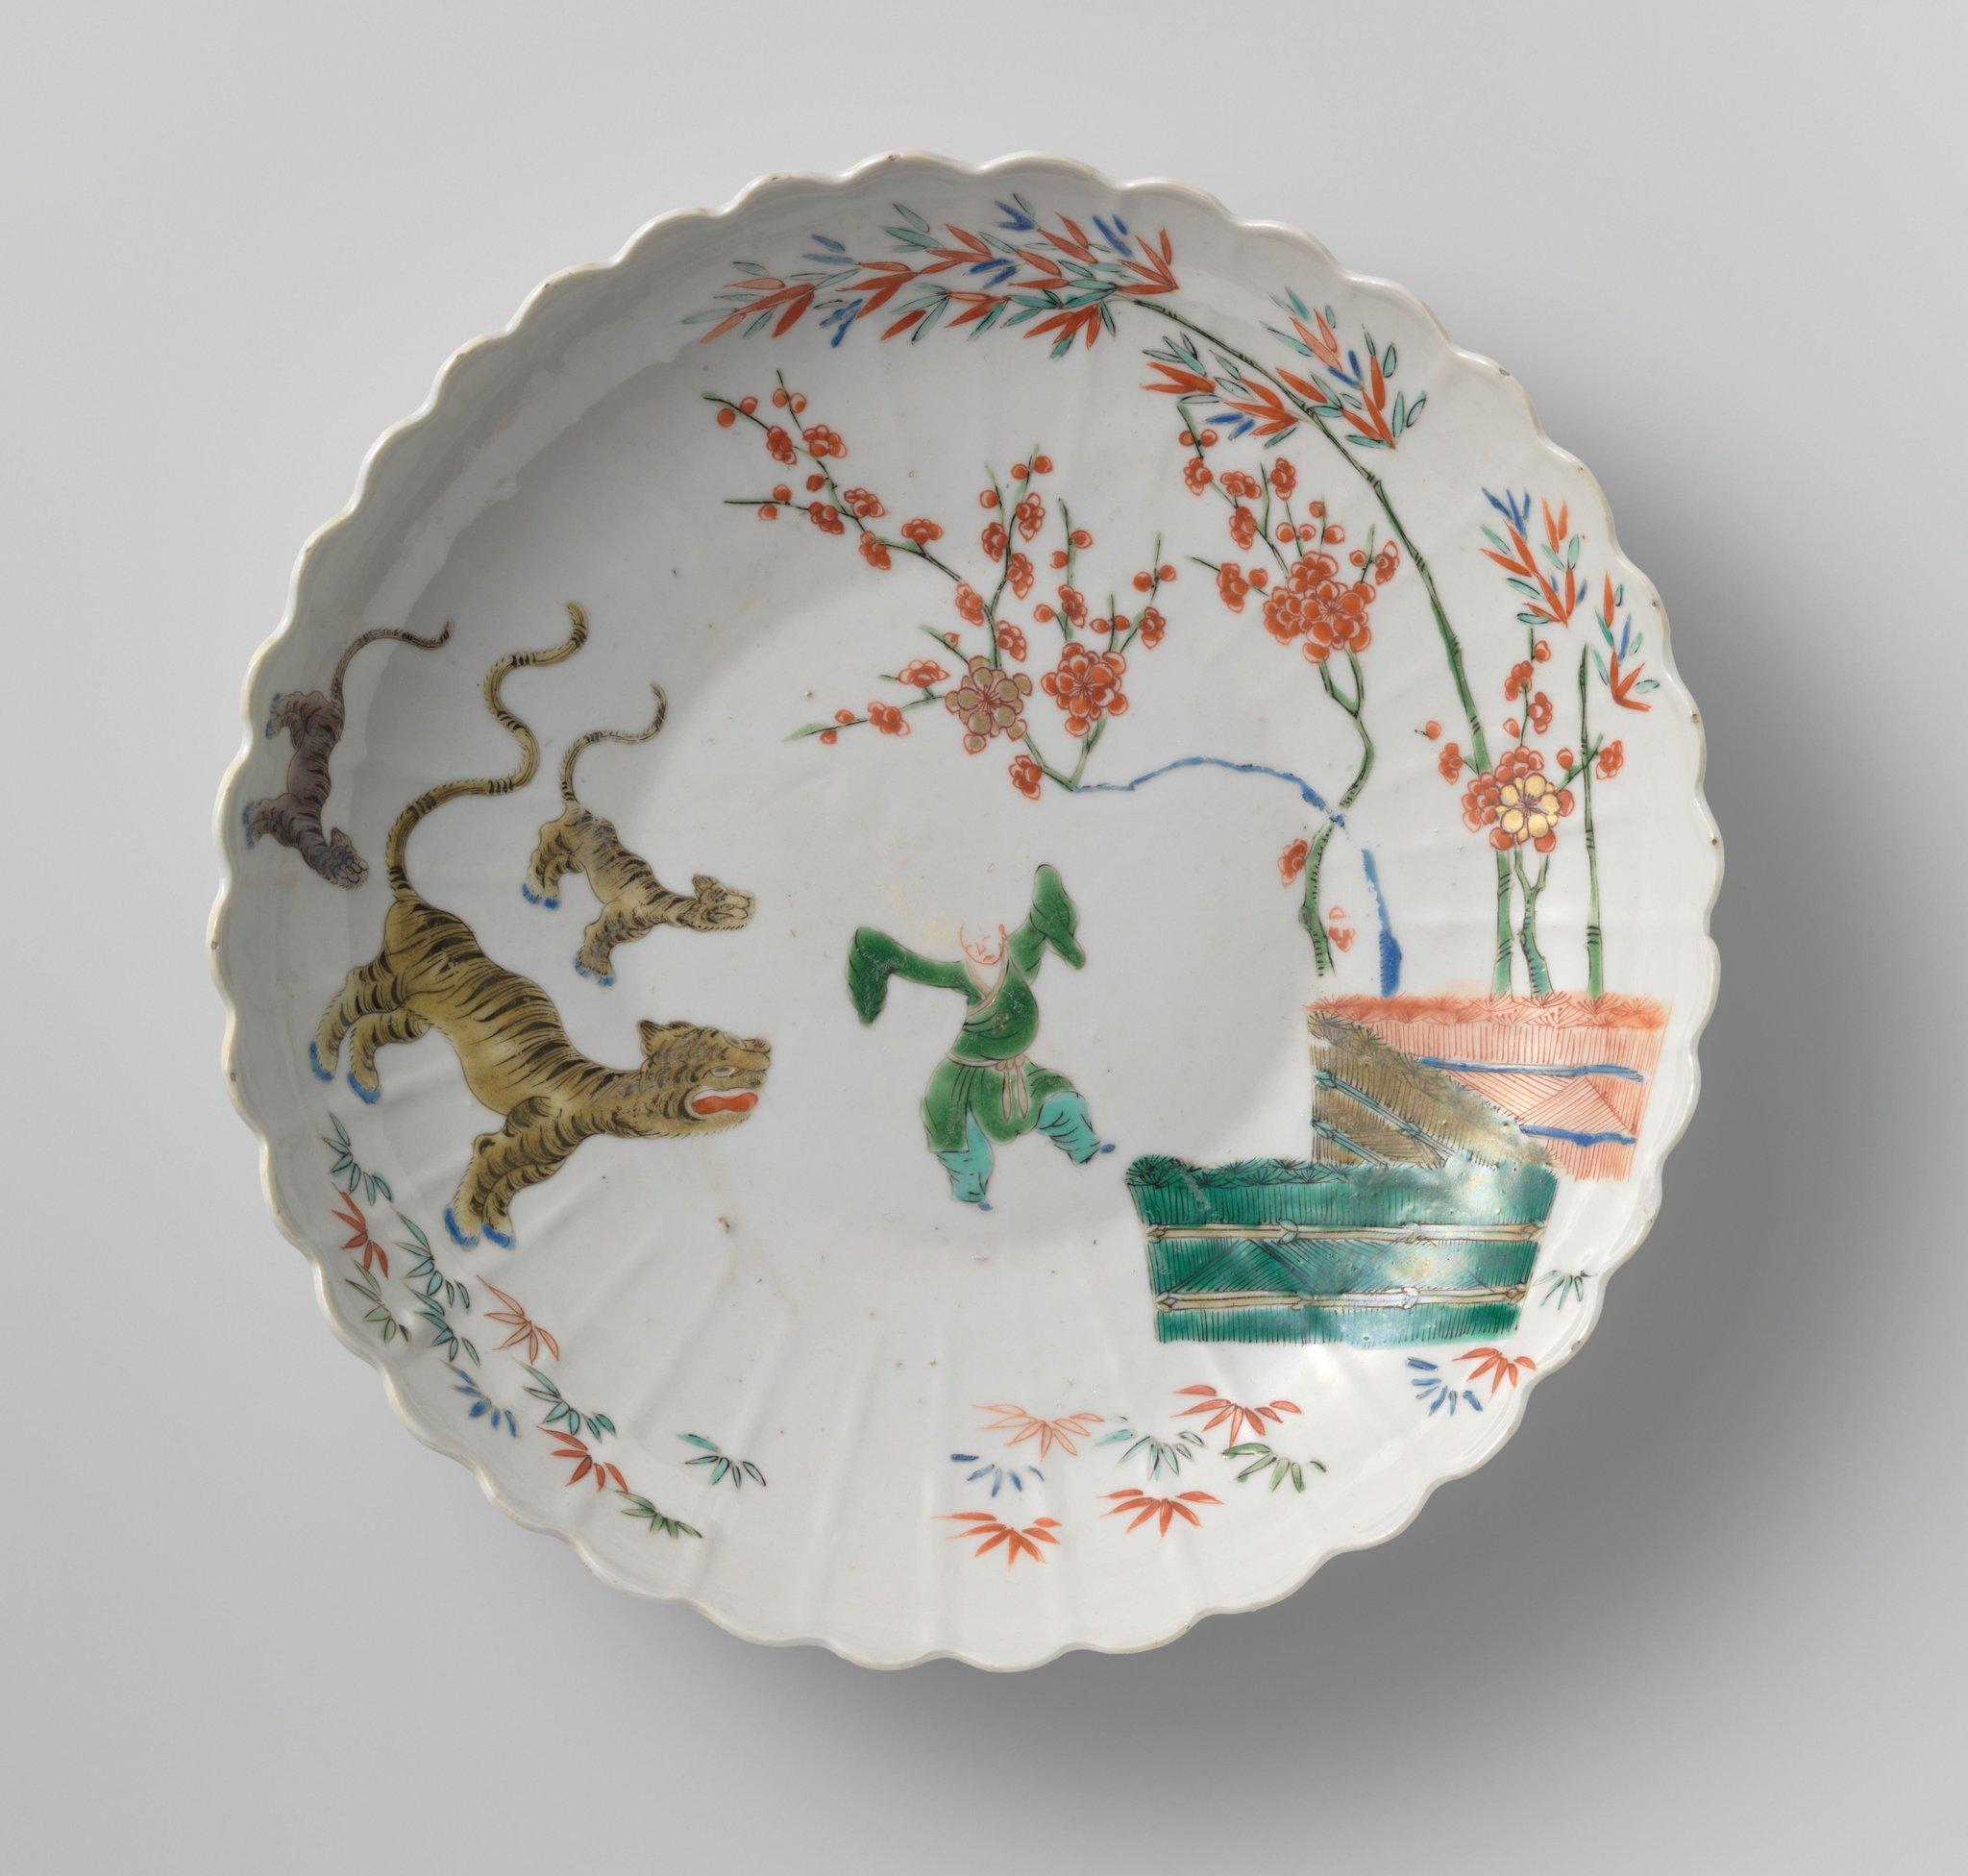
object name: dish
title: Saucer-dish with bamboo, prunus, tiger and a Chinese boy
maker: Anonymous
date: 1700-1724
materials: glaze, gold, paint, porcelain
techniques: firing, gilding, turning, vitrification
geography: china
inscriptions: label: ‘Collectie Westendorp/ 10’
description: Schaal van porselein met een geribde wand en gelobde rand, beschilderd op het glazuur in blauw, rood, groen, geel, zwart en goud. Op de voorzijde een dansende Chinese jongen tussen drie tijgers aan de ene kant en bamboe en prunustak achter bijeengebonden heggen aan de andere kant. Een chip en een barst in de rand. Oud label op de onderzijde met 'Collectie Westendorp/ 10'. Famille verte in de Japanse Kakiemon-stijl.